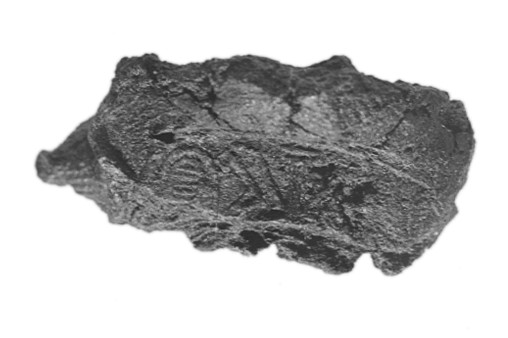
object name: sealing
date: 2030-1640 BCE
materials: clay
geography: egypt